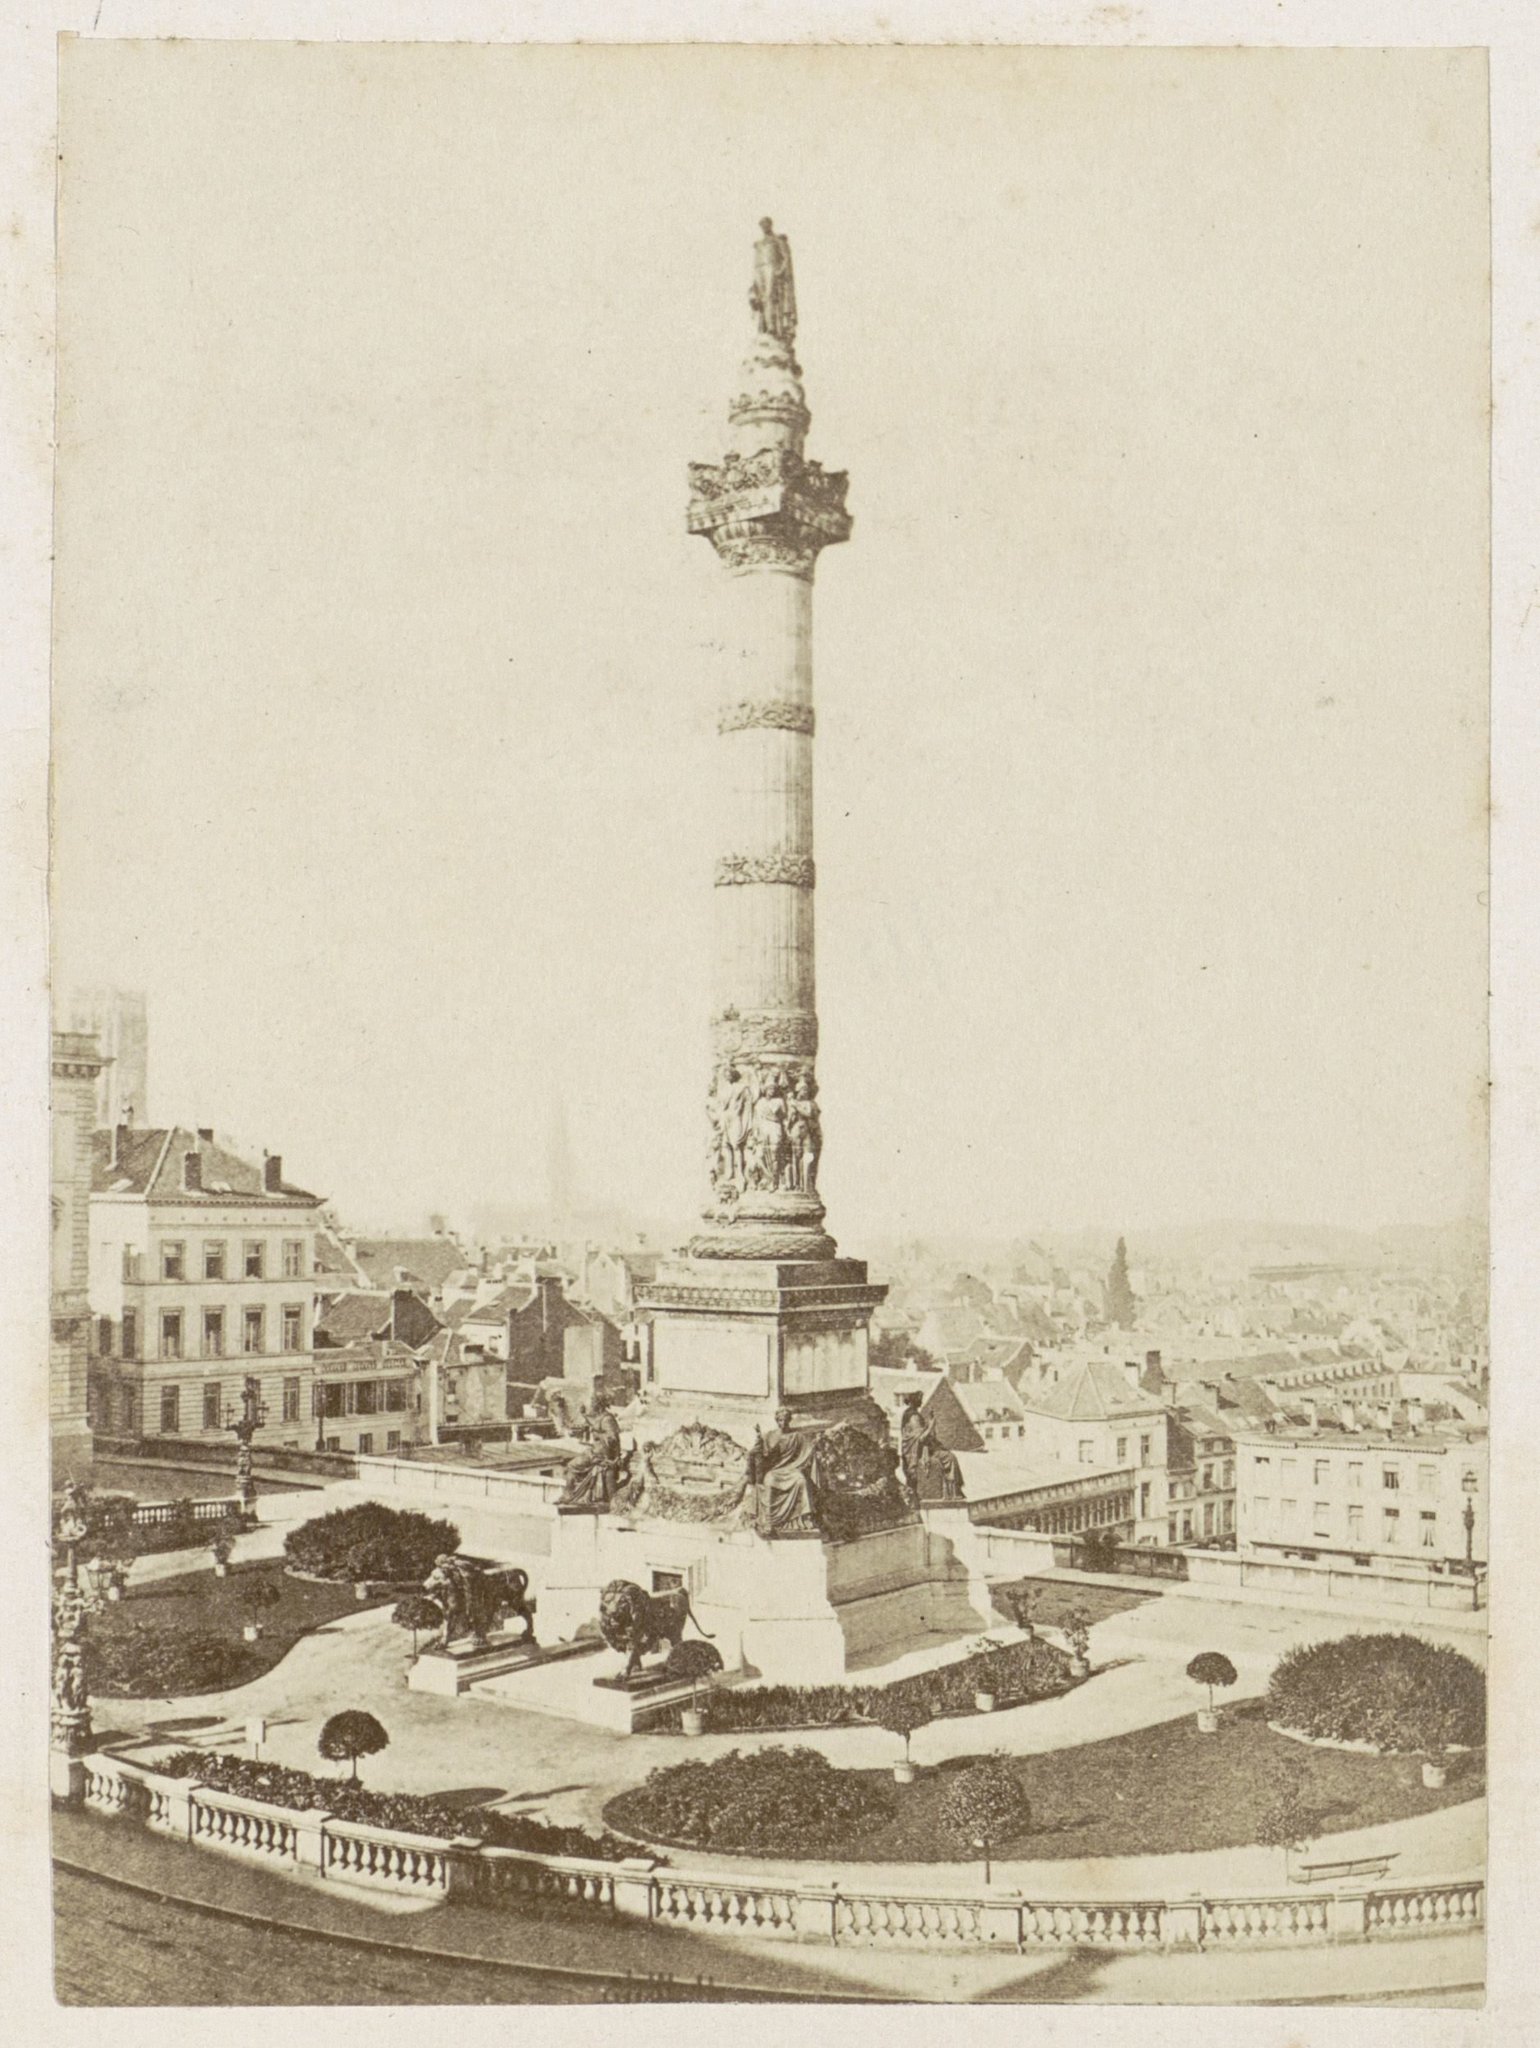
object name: photograph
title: Congreskolom met het standbeeld van koning Leopold I in Brussel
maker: Anonymous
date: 1878-1890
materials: photographic support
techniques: albumen print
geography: brussels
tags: piece of sculpture, reproduction of a piece of sculpture (+ sculpture), monument, statue, brussels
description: Onderdeel van Reisalbum Europese steden, vermoedelijk Zweeds.